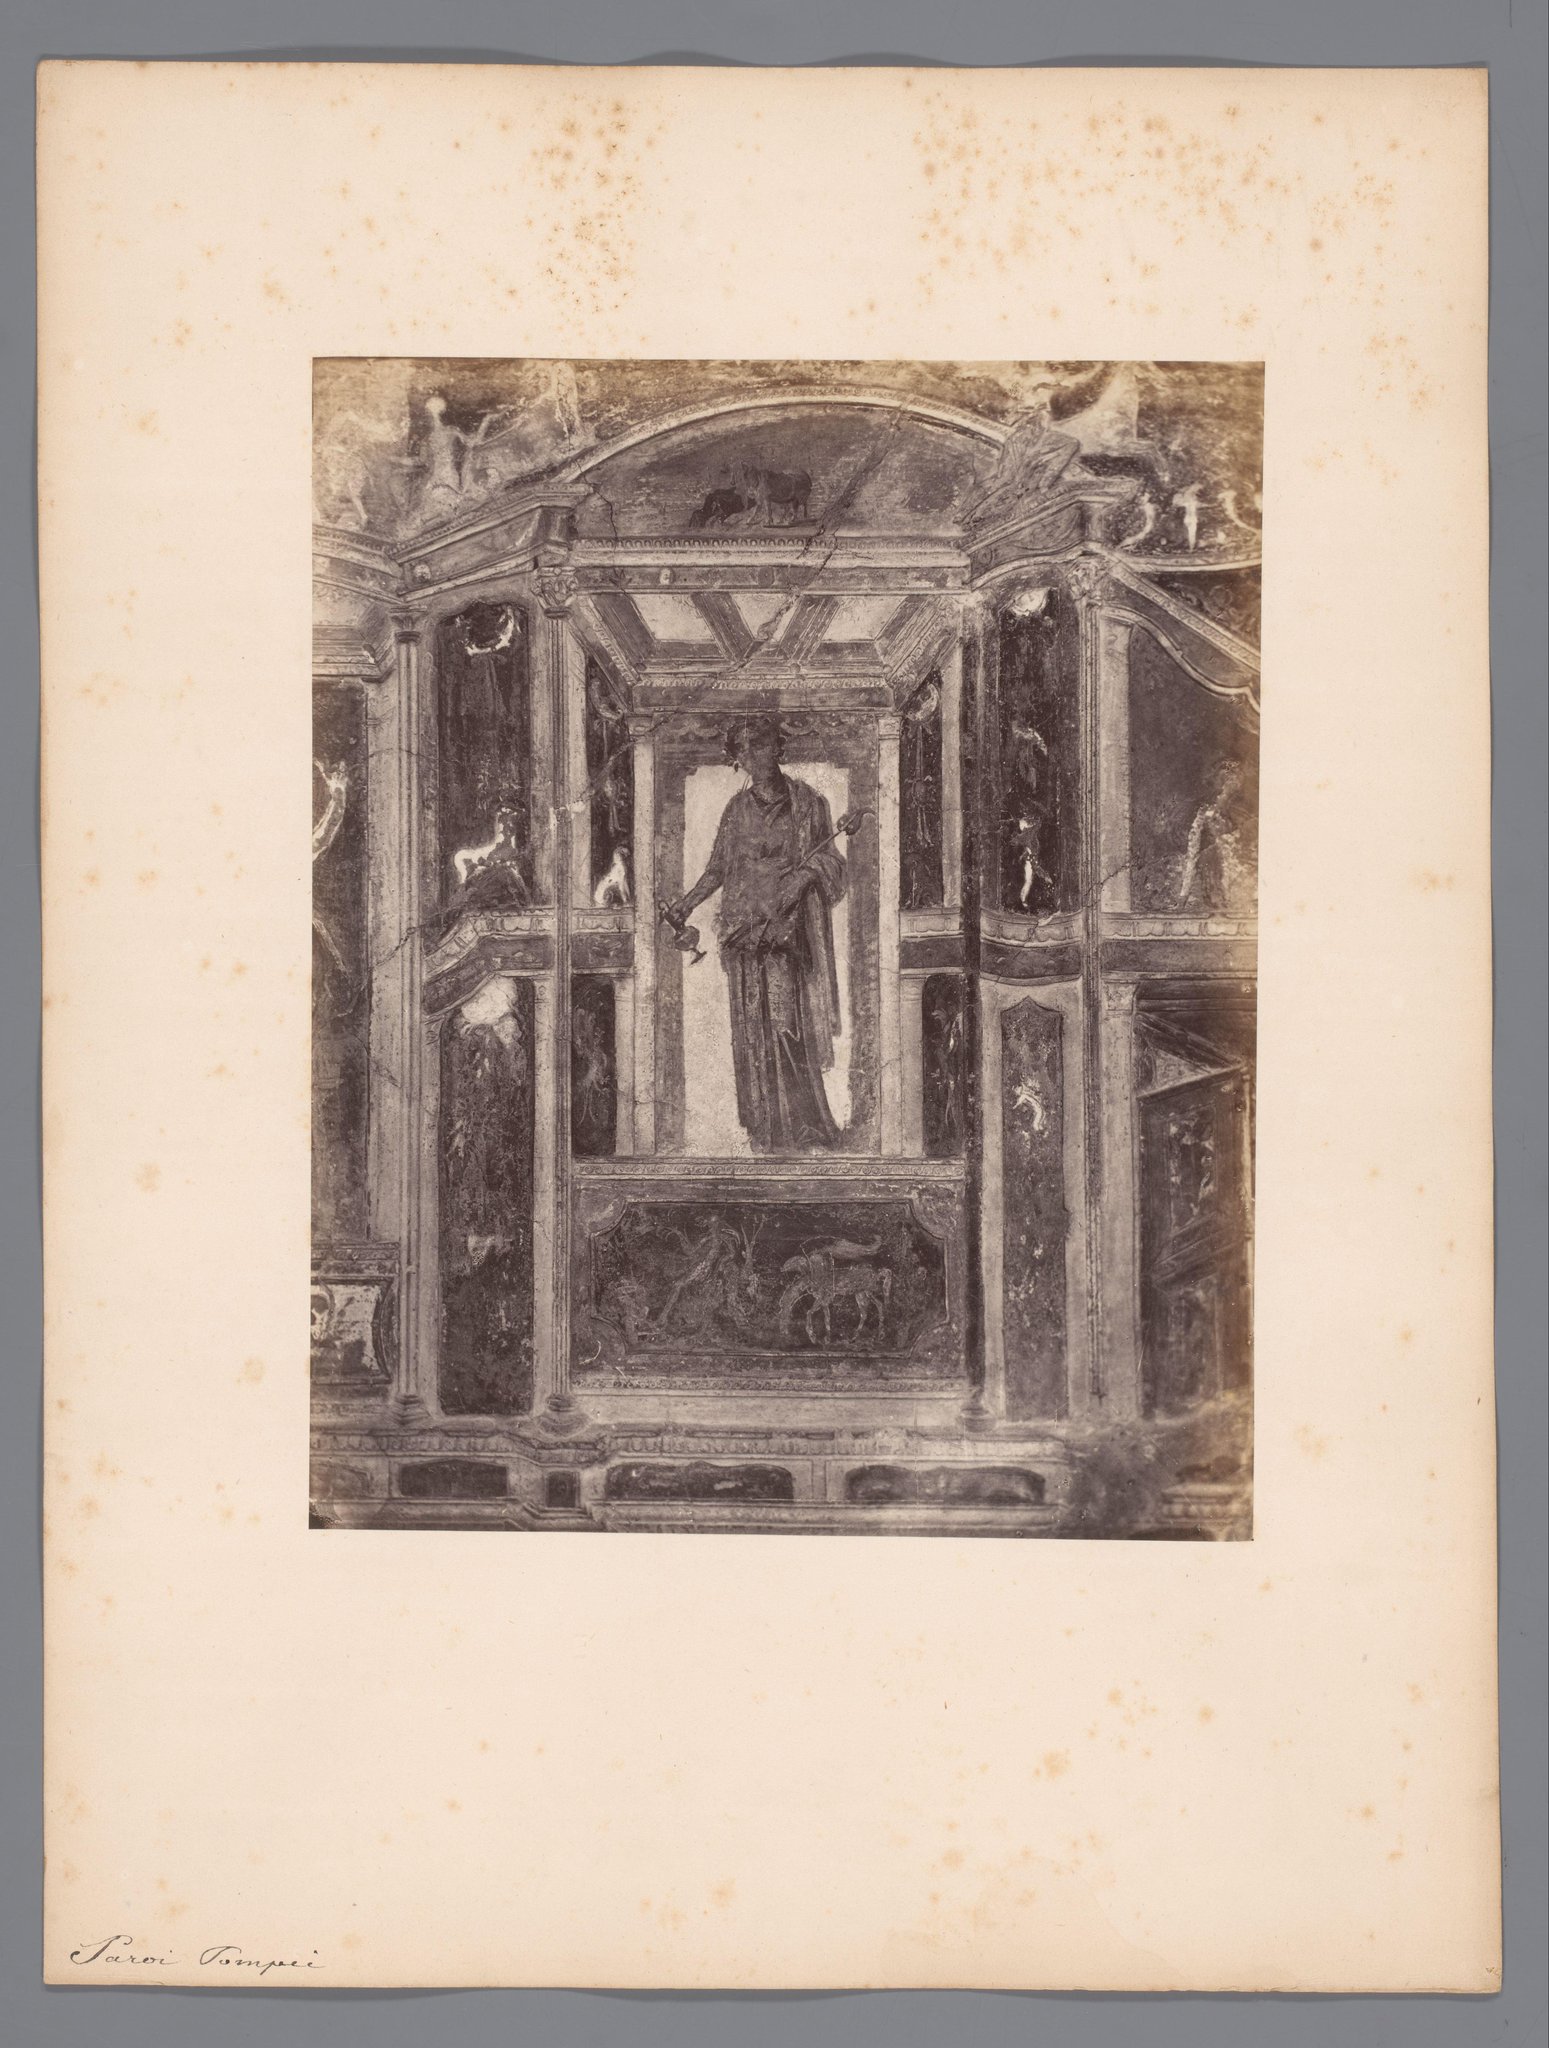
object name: photograph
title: Fotoreproductie van een fresco voorstellende een staande man te Pompeï, Italië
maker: Anonymous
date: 1851-1900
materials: cardboard, paper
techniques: albumen print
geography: pompeii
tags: picture, painting, wall-covering, pompeii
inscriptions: number: ‘11’, number: ‘76.’, inscription: ‘Paroi Pompei’